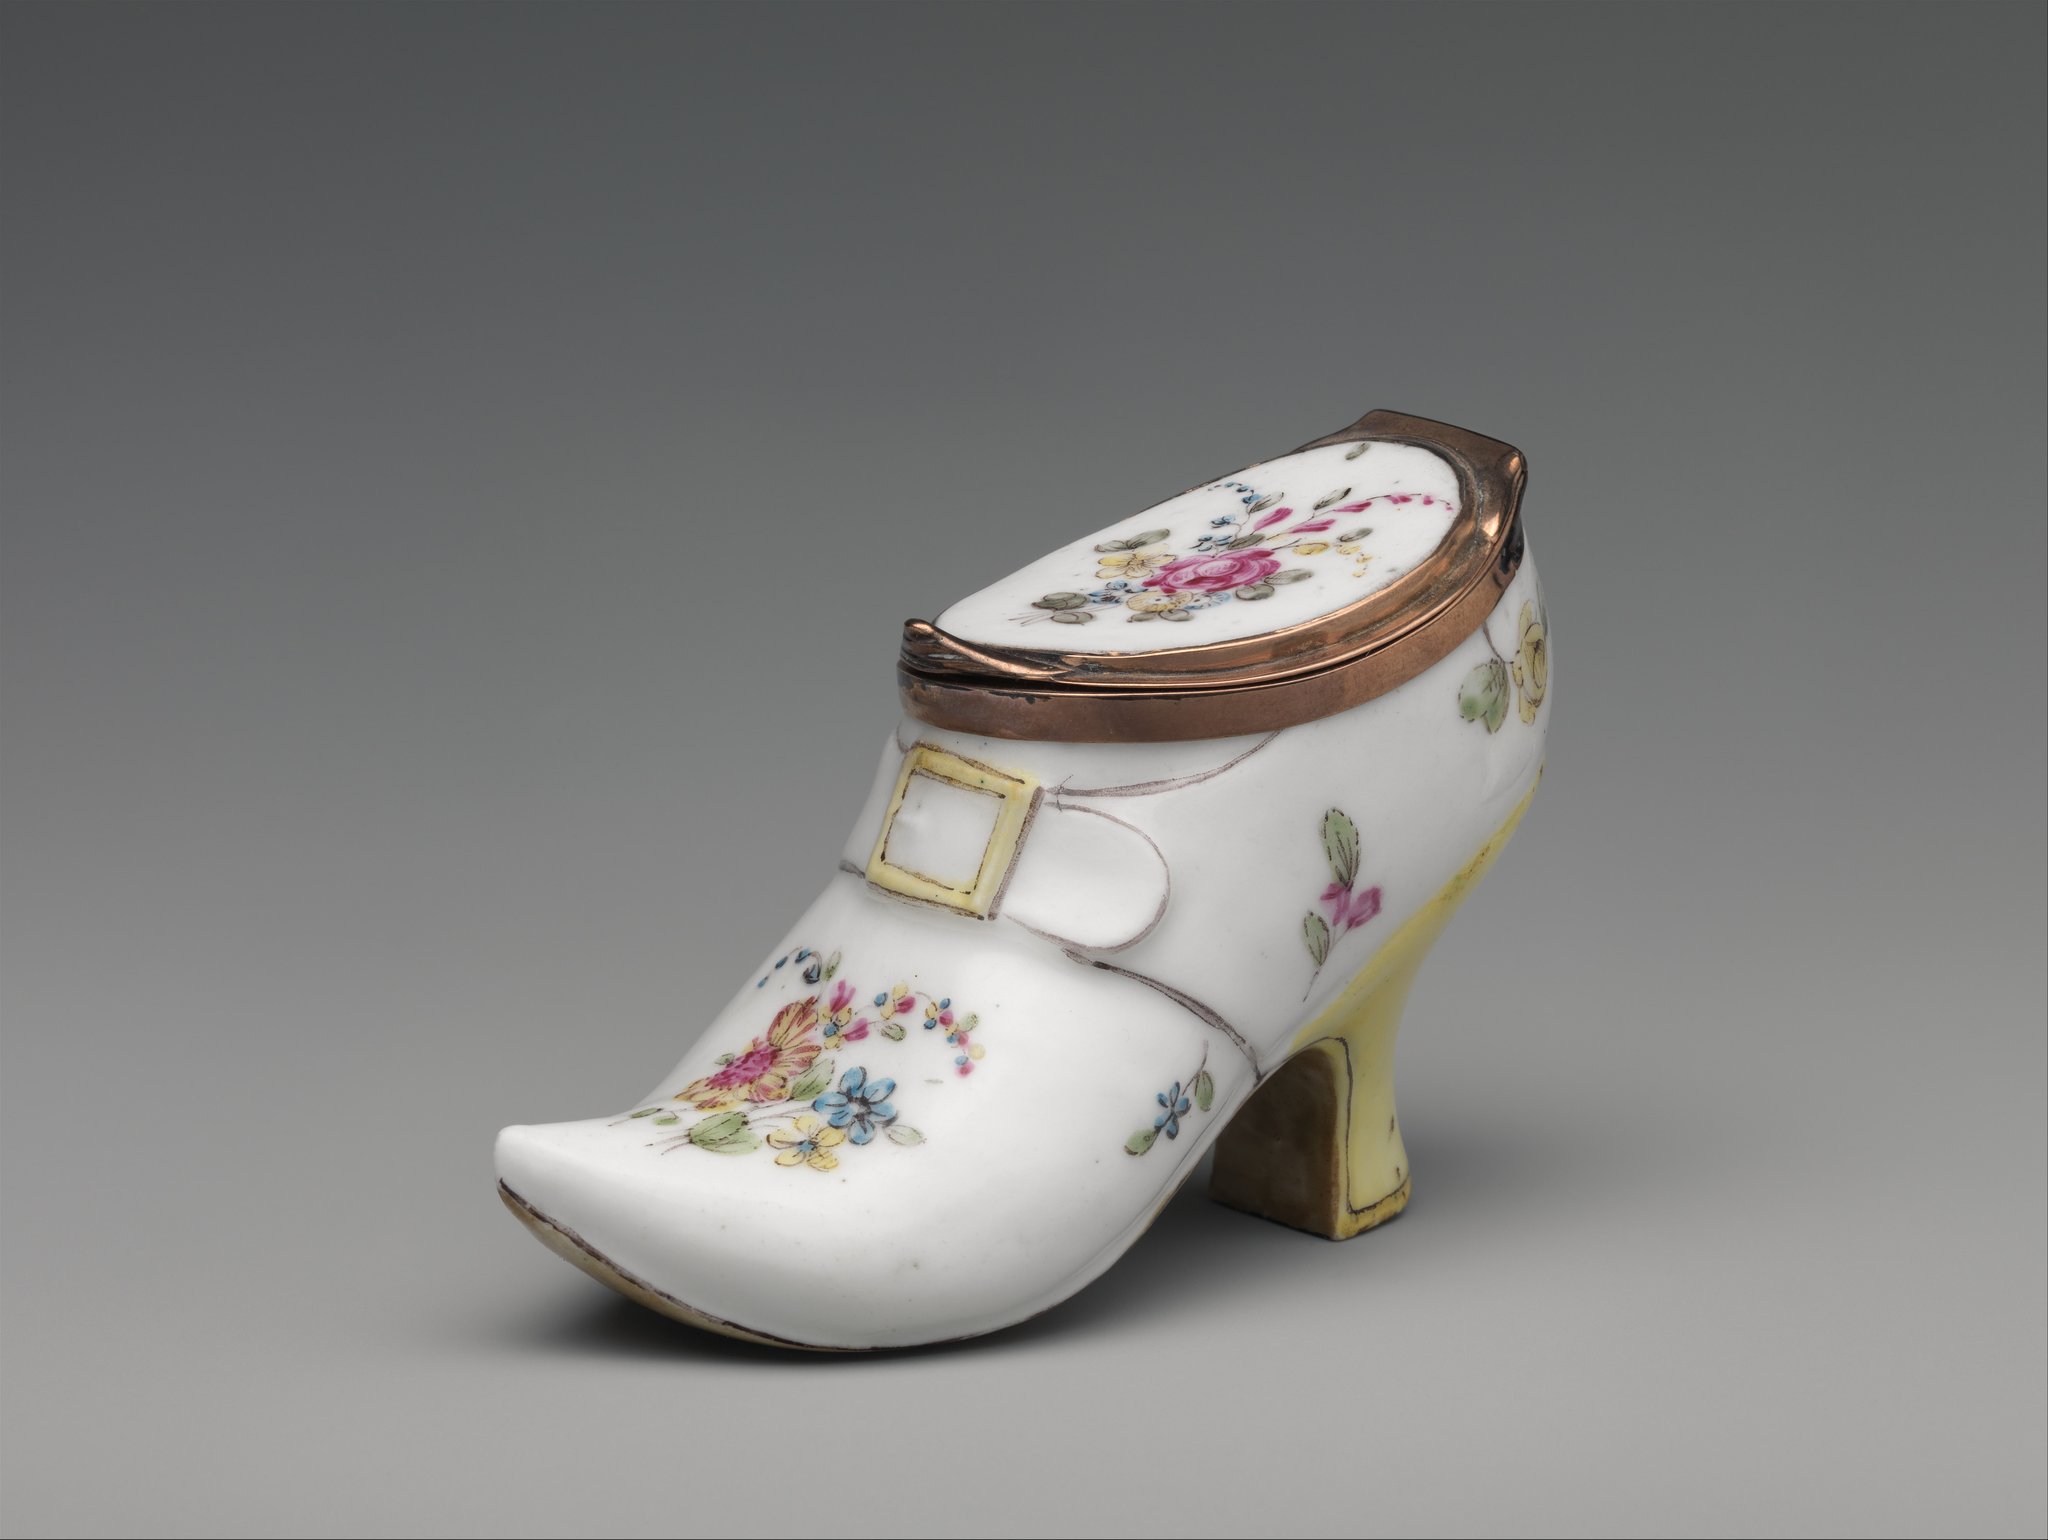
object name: snuffbox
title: Snuffbox in the form of a slipper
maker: mennecy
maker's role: factory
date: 1750-1760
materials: gold, soft paste porcelain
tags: flowers